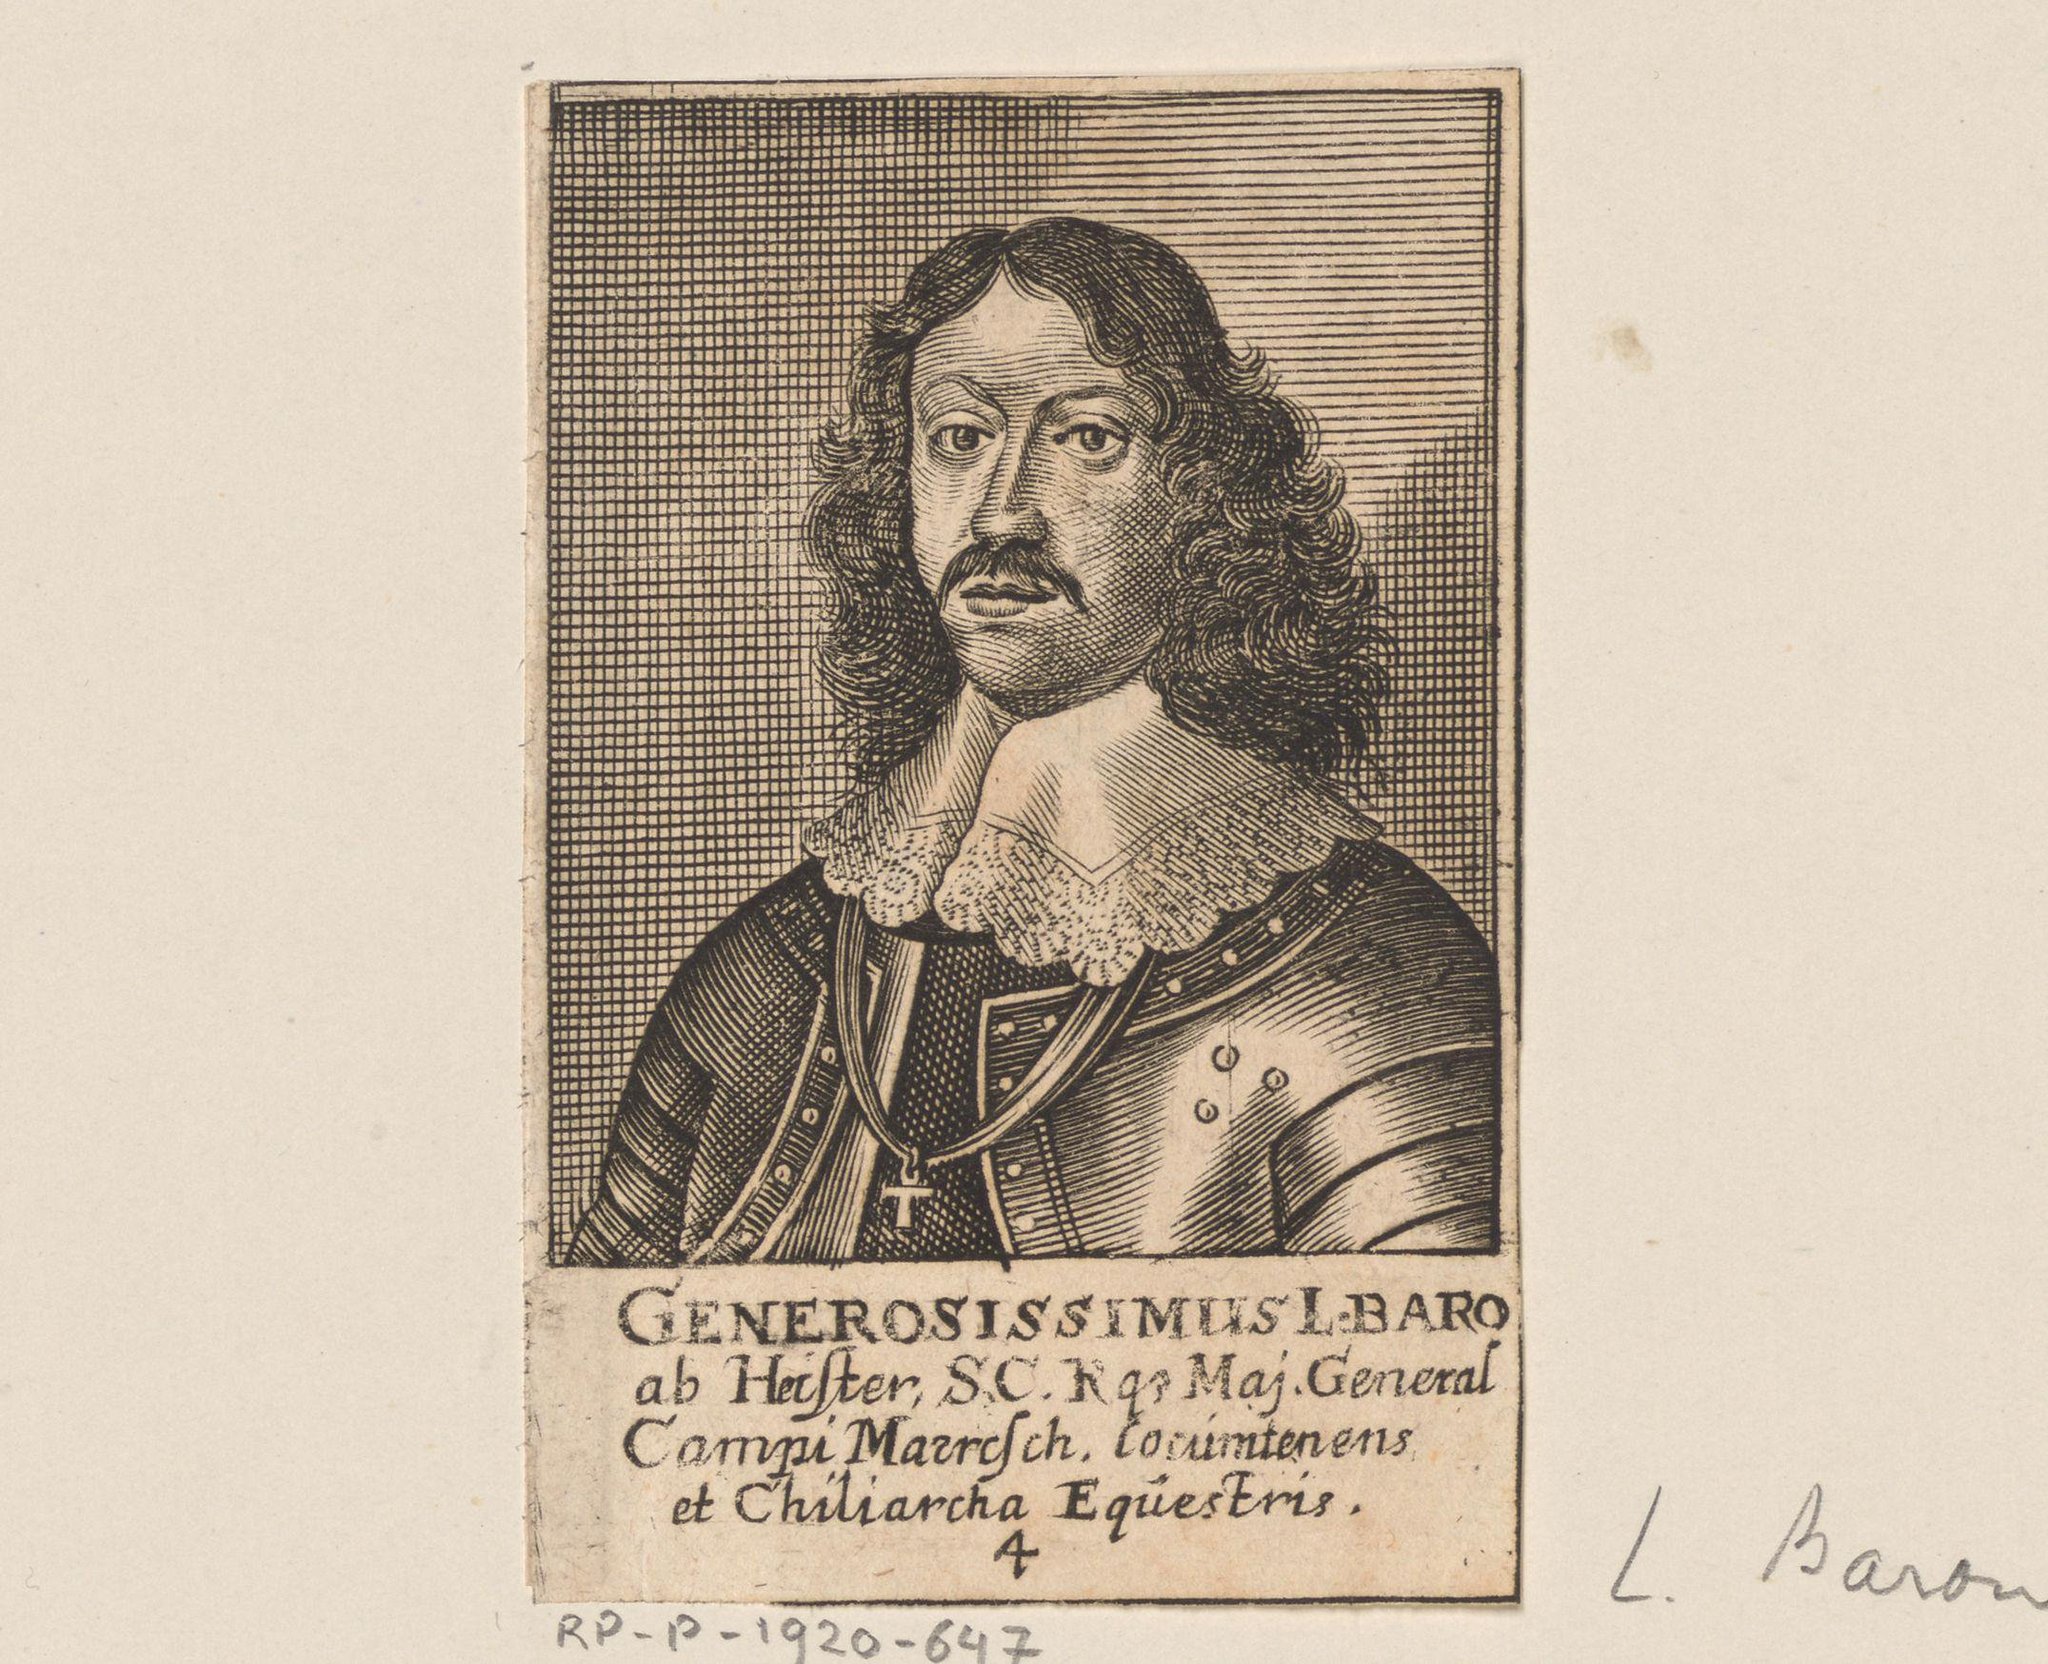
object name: print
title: Portret van Gottfried Heister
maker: Anonymous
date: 1675-1724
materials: paper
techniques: engraving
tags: commander-in-chief, general, marshal, armour, historical persons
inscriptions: collector's mark: Lugt 2228